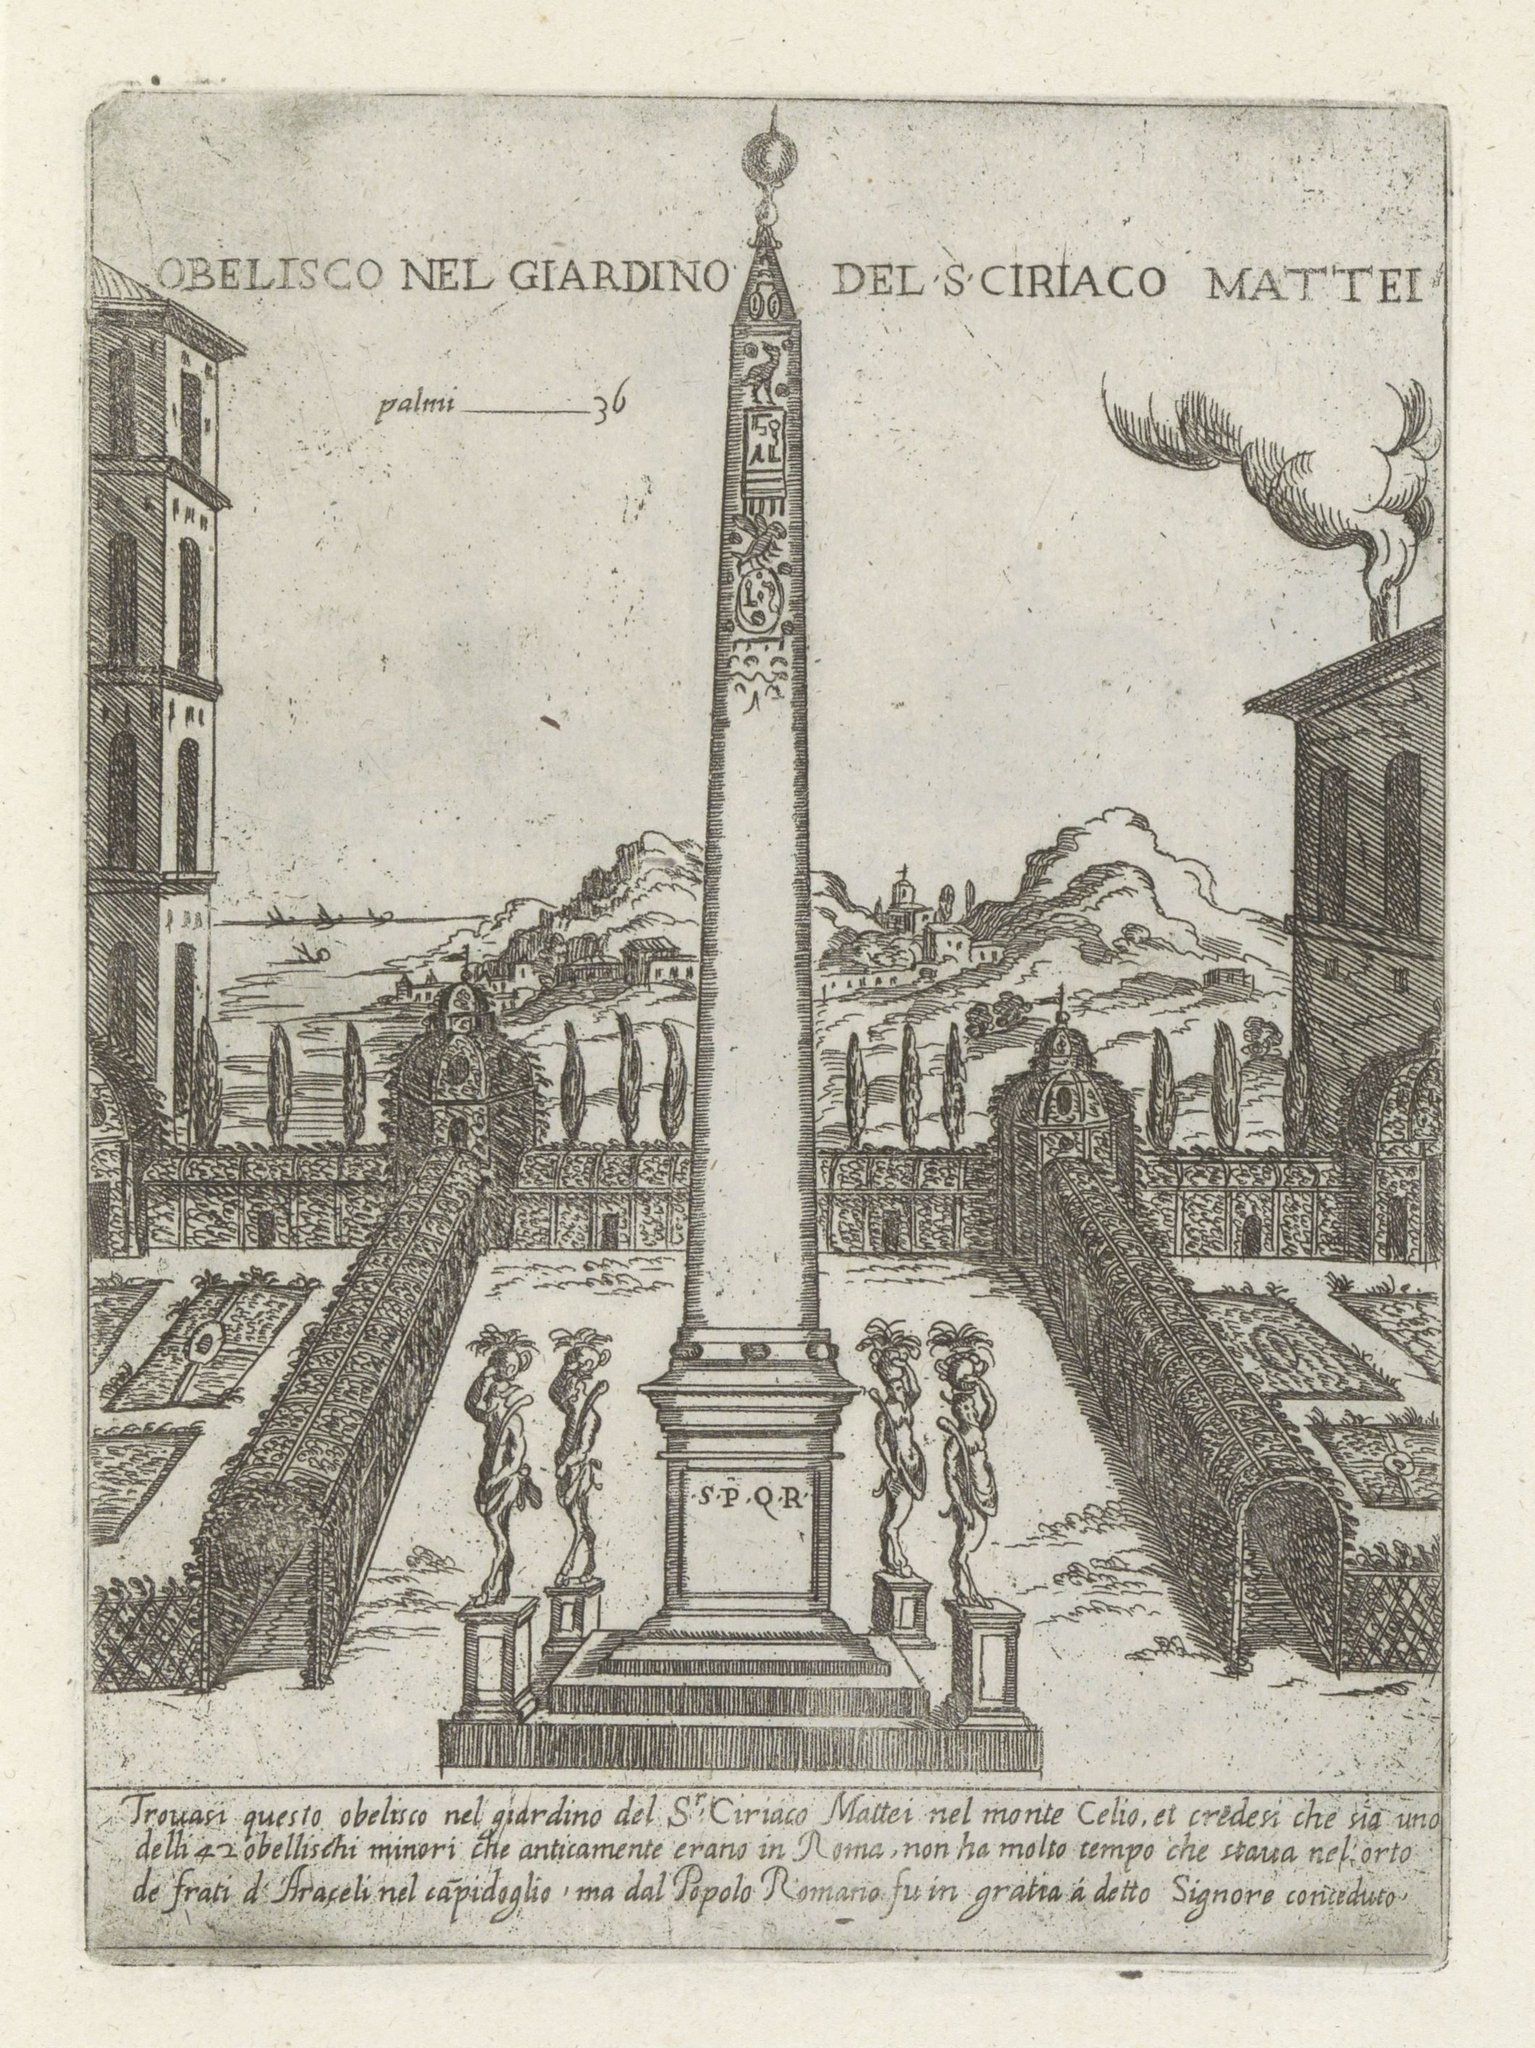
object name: album leaf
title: Ornamenti di fabriche antichi et moderni dell' alma citta di Roma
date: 1576-1618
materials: paper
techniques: etching, intaglio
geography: rome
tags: obelisk, needle, garden, rome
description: De Egyptische obelisk in de tuin van Ciriaco Mattei te Rome. Italiaanse tekst in ondermarge. De prent maakt deel uit van een album.